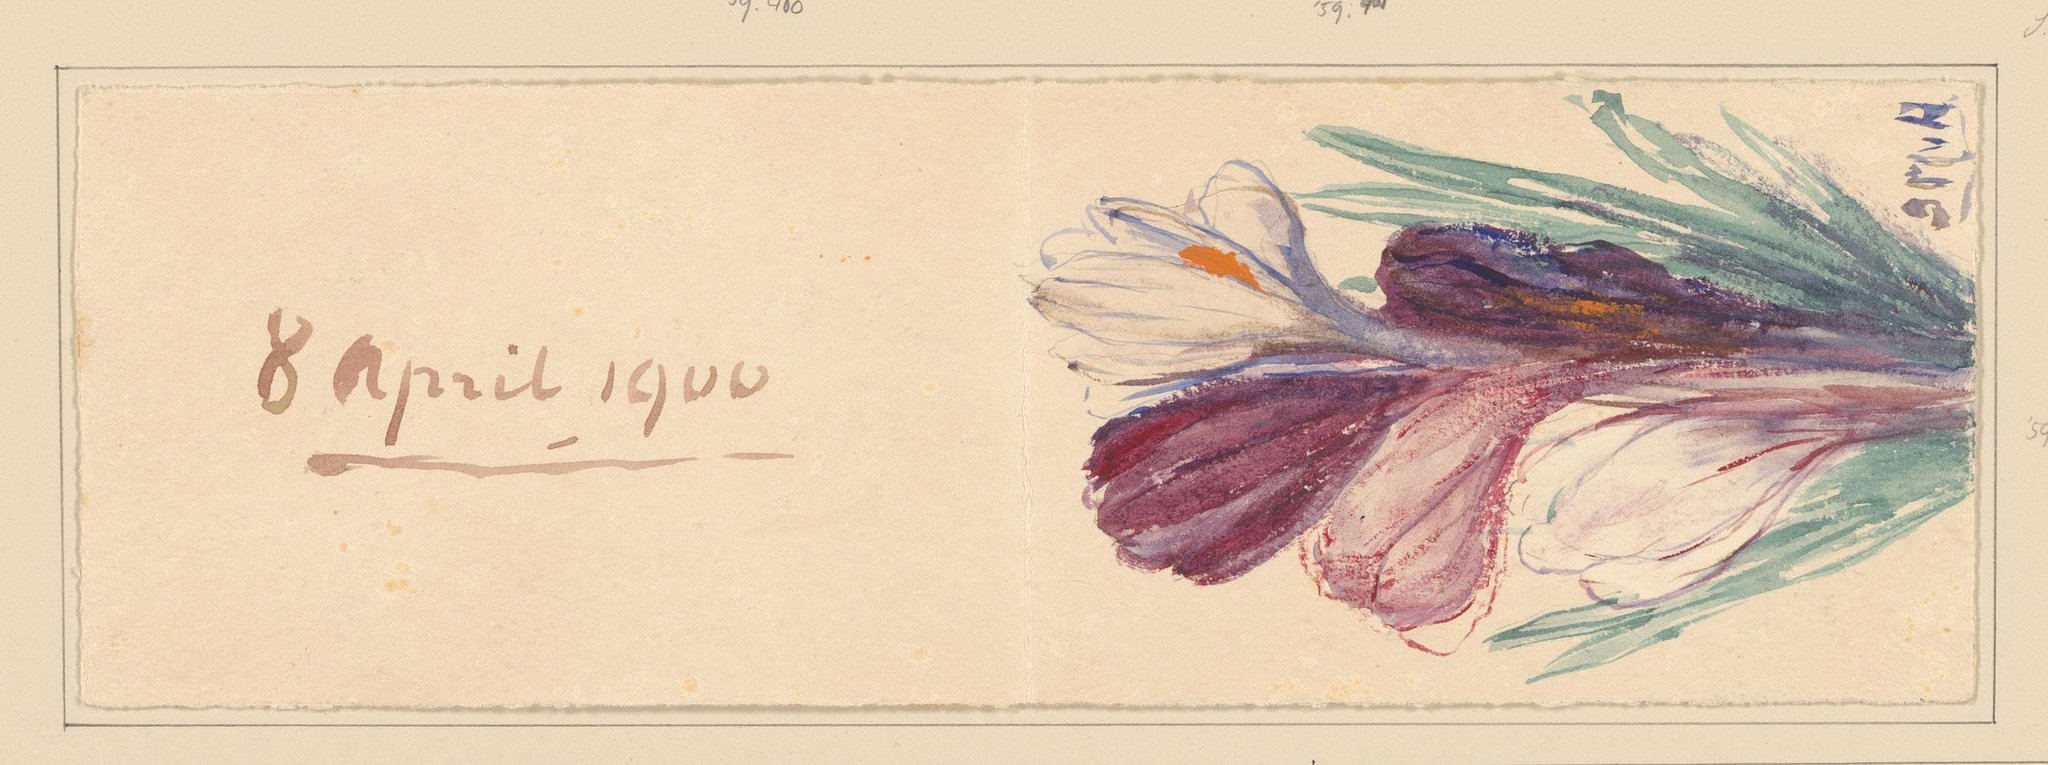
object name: drawing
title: Krokussen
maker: sientje mesdag-van houten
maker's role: draughtsman, painter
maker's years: 1834-1909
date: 1900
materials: paper, watercolor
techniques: brush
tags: flowers: crocus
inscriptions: date